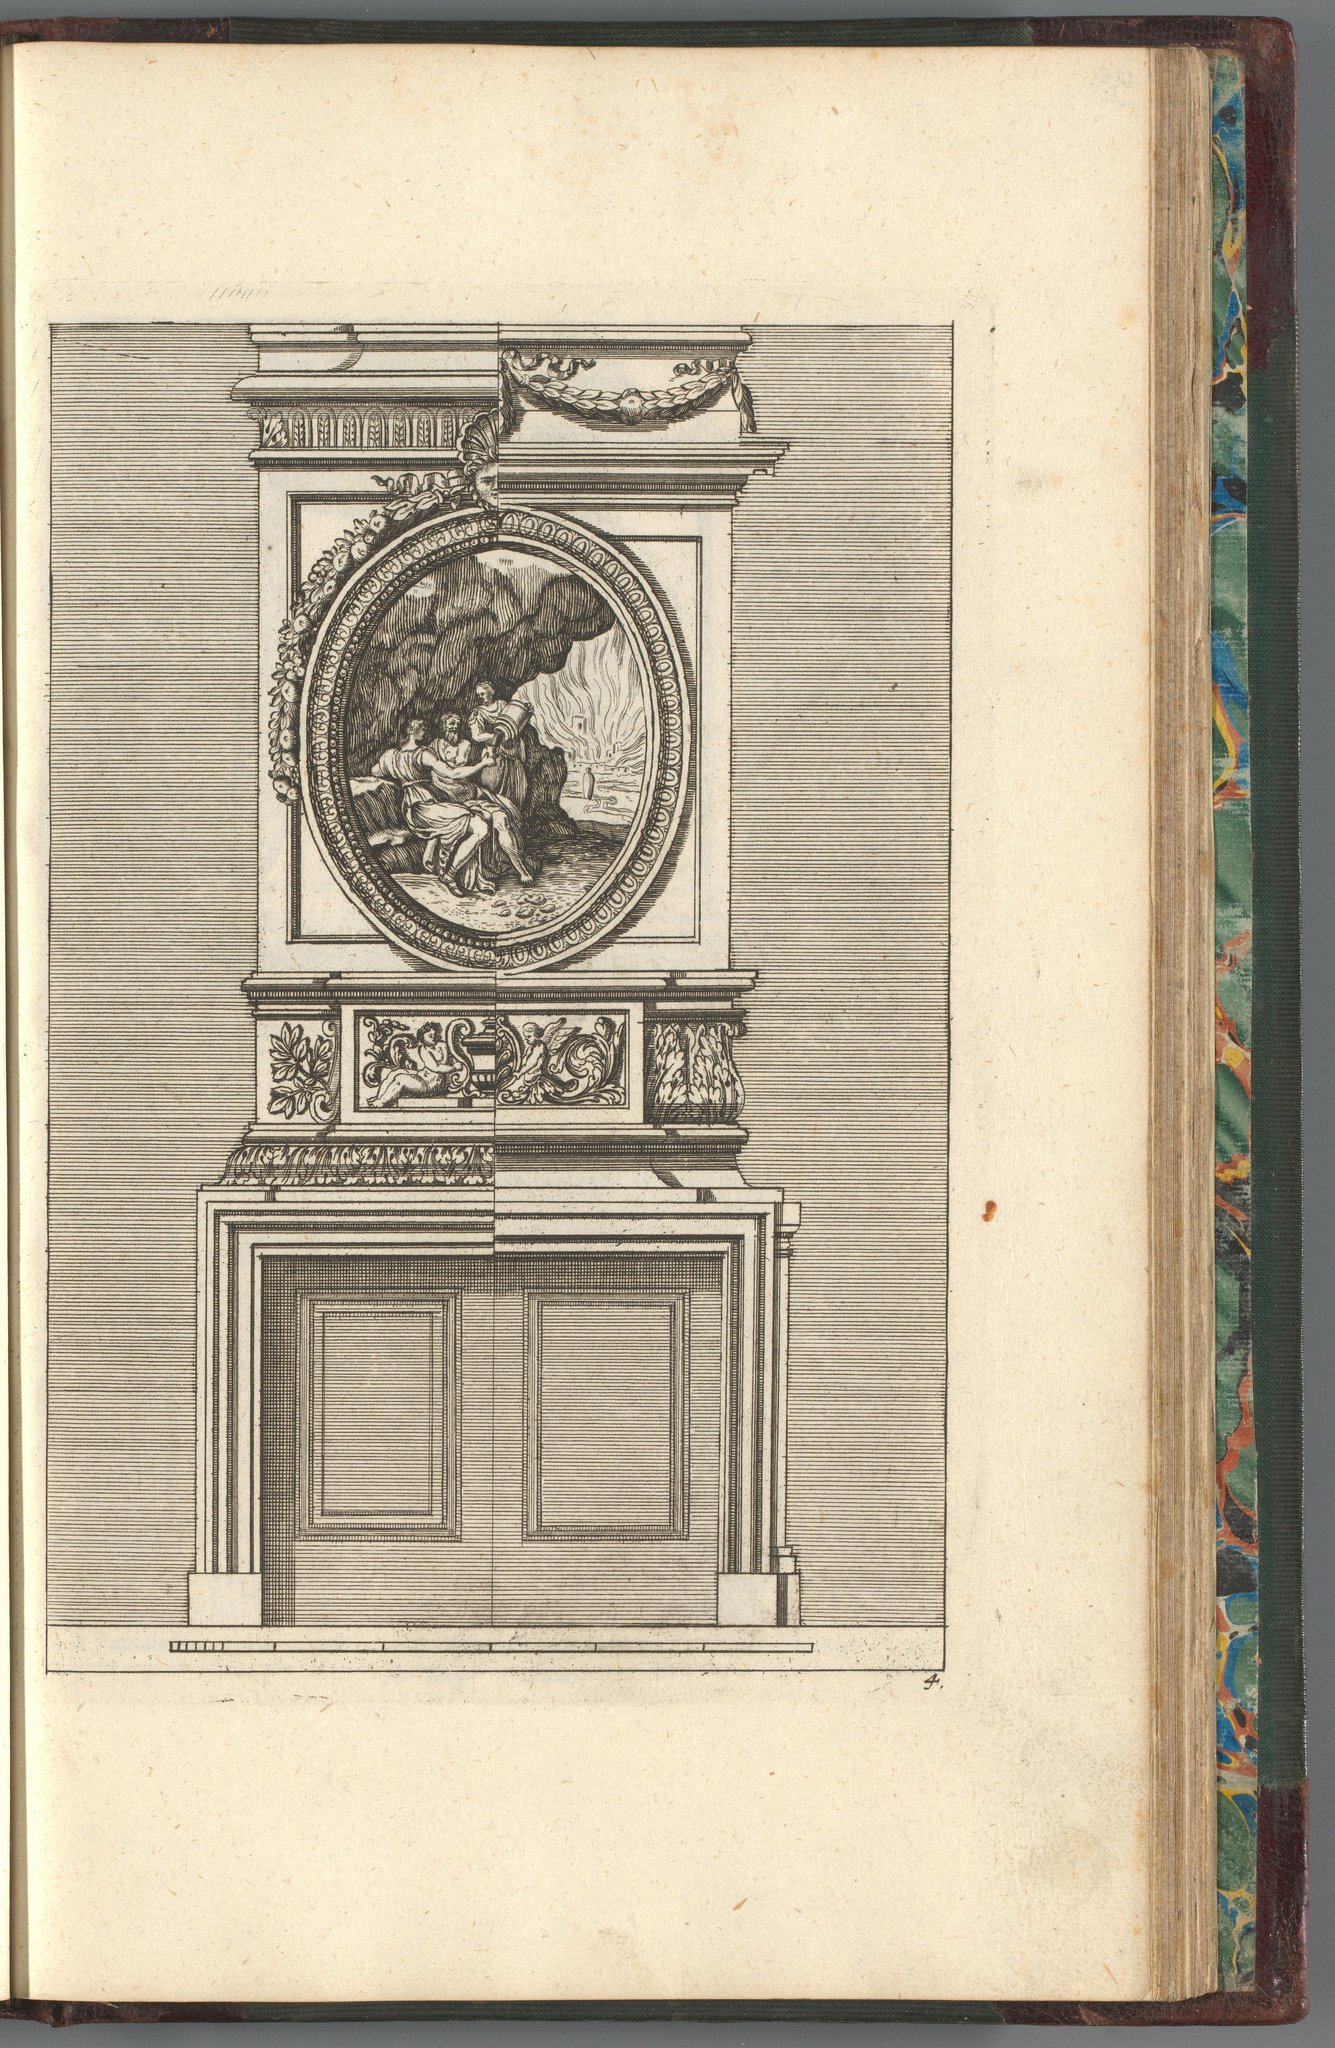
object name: ornament print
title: Livre de Cheminees a la Moderne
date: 1686-1724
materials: paper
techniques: etching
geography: augsburg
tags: ornaments ~ art, chimney-piece, mantelpiece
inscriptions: number: ‘4.’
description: Ontwerp van een schoorsteenmantel met en ovaal schilderij met op de voorgrond twee mannen en een vrouw met een waterkan en op de achtergrond een brandende stad. Vierde prent uit een serie van zes. Prent maakt deel uit van een album. Hoogstwaarschijnlijk kopie naar Frans origineel.